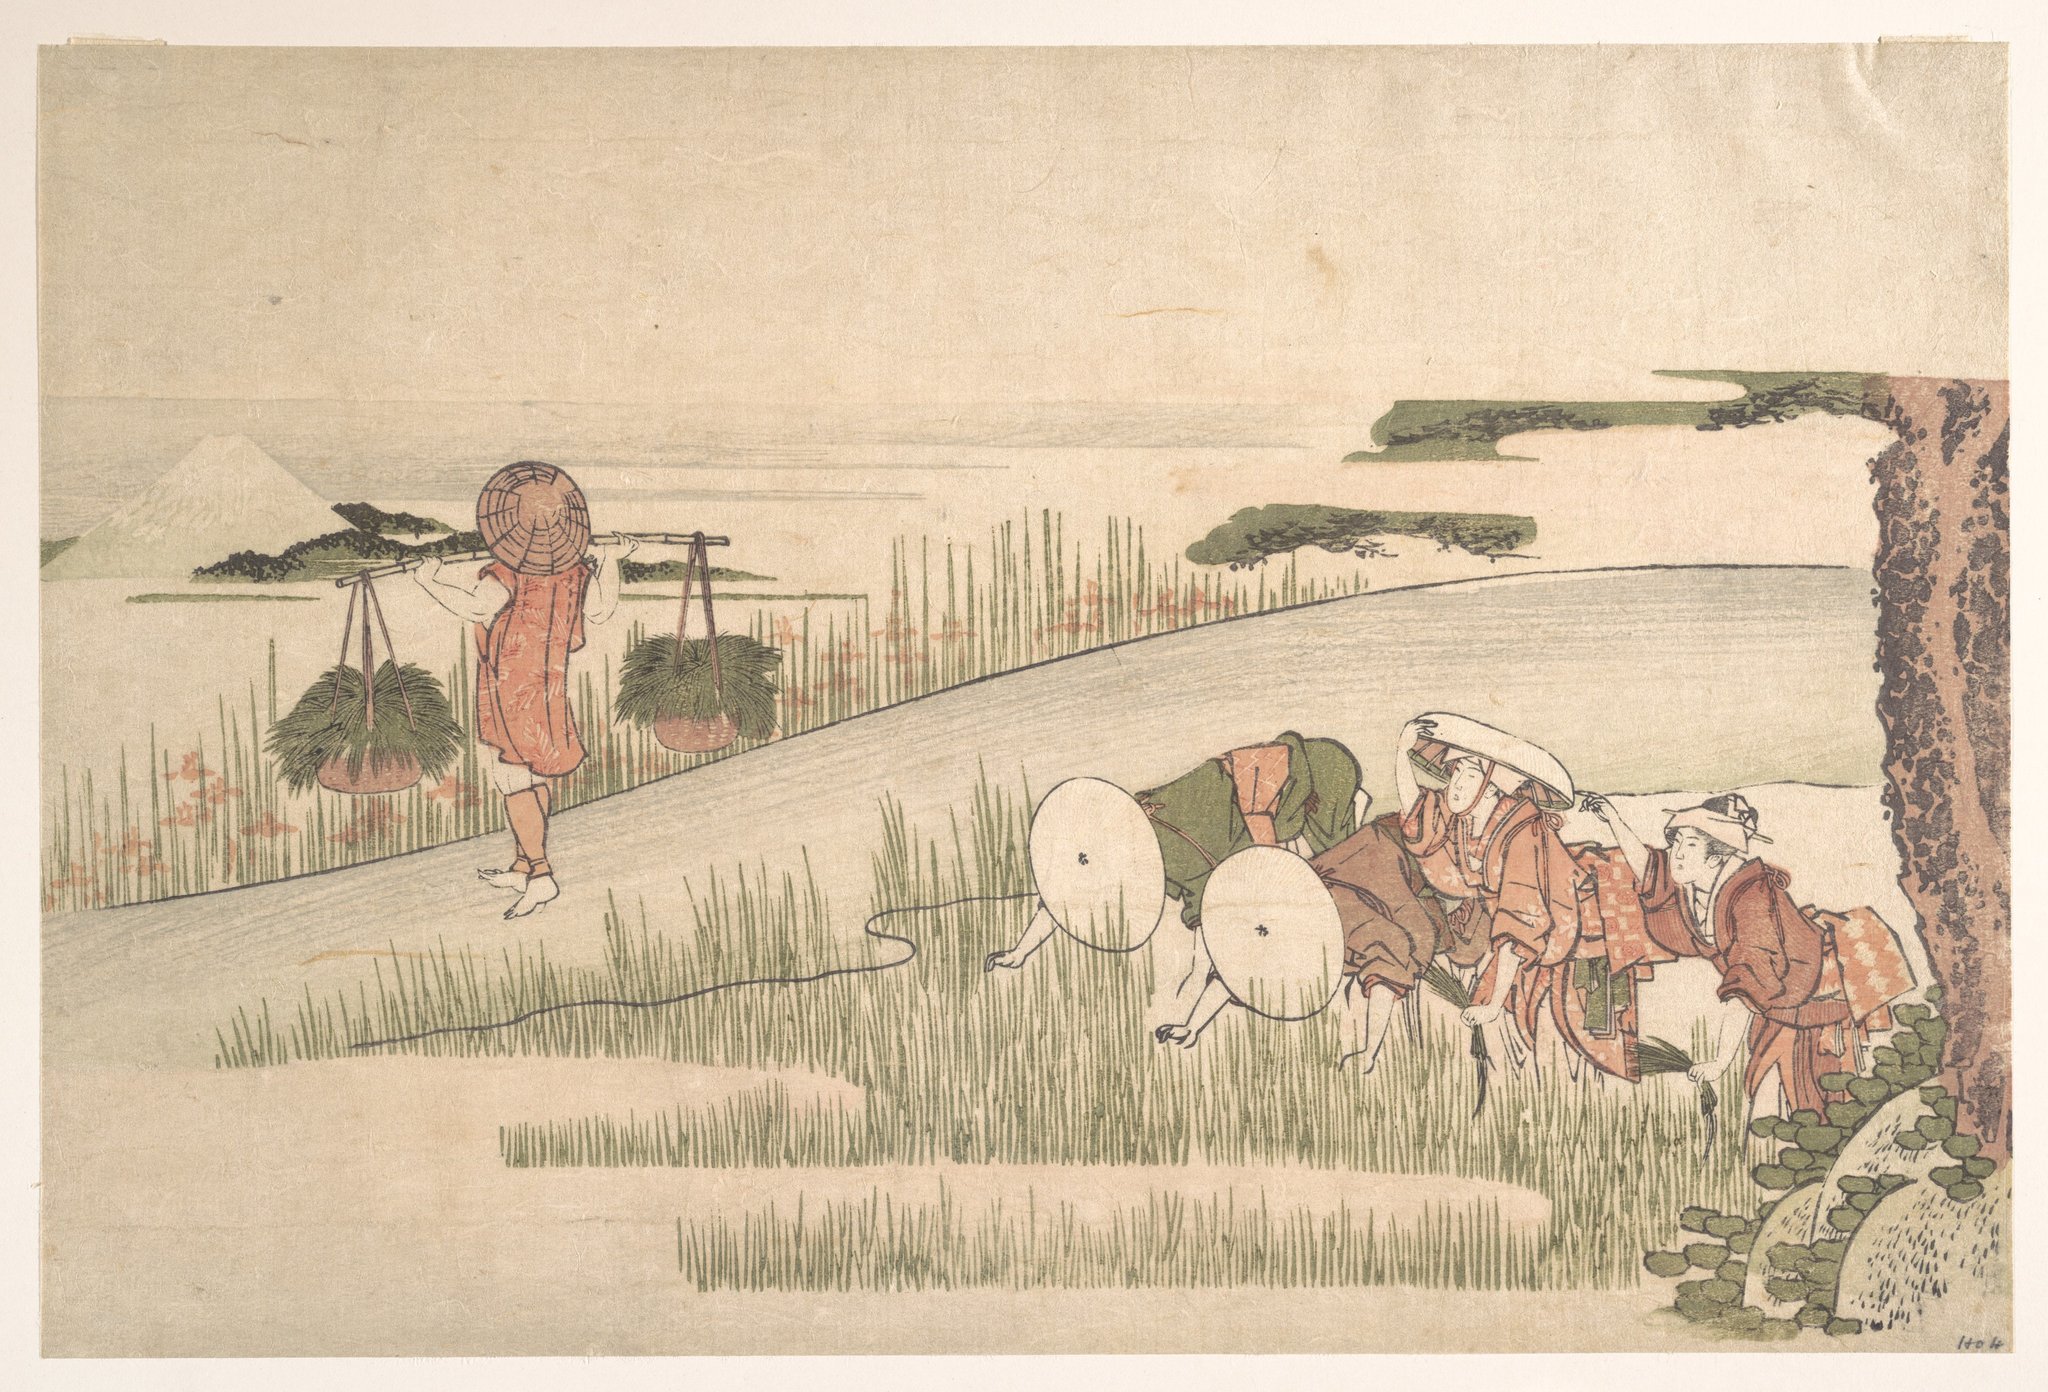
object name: print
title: Spring in the Rice Fields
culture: japanese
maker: katsushika hokusai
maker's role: artist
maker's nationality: japanese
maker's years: 1760-1849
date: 1800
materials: ink, paper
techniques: woodblock print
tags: human figures,spring,working